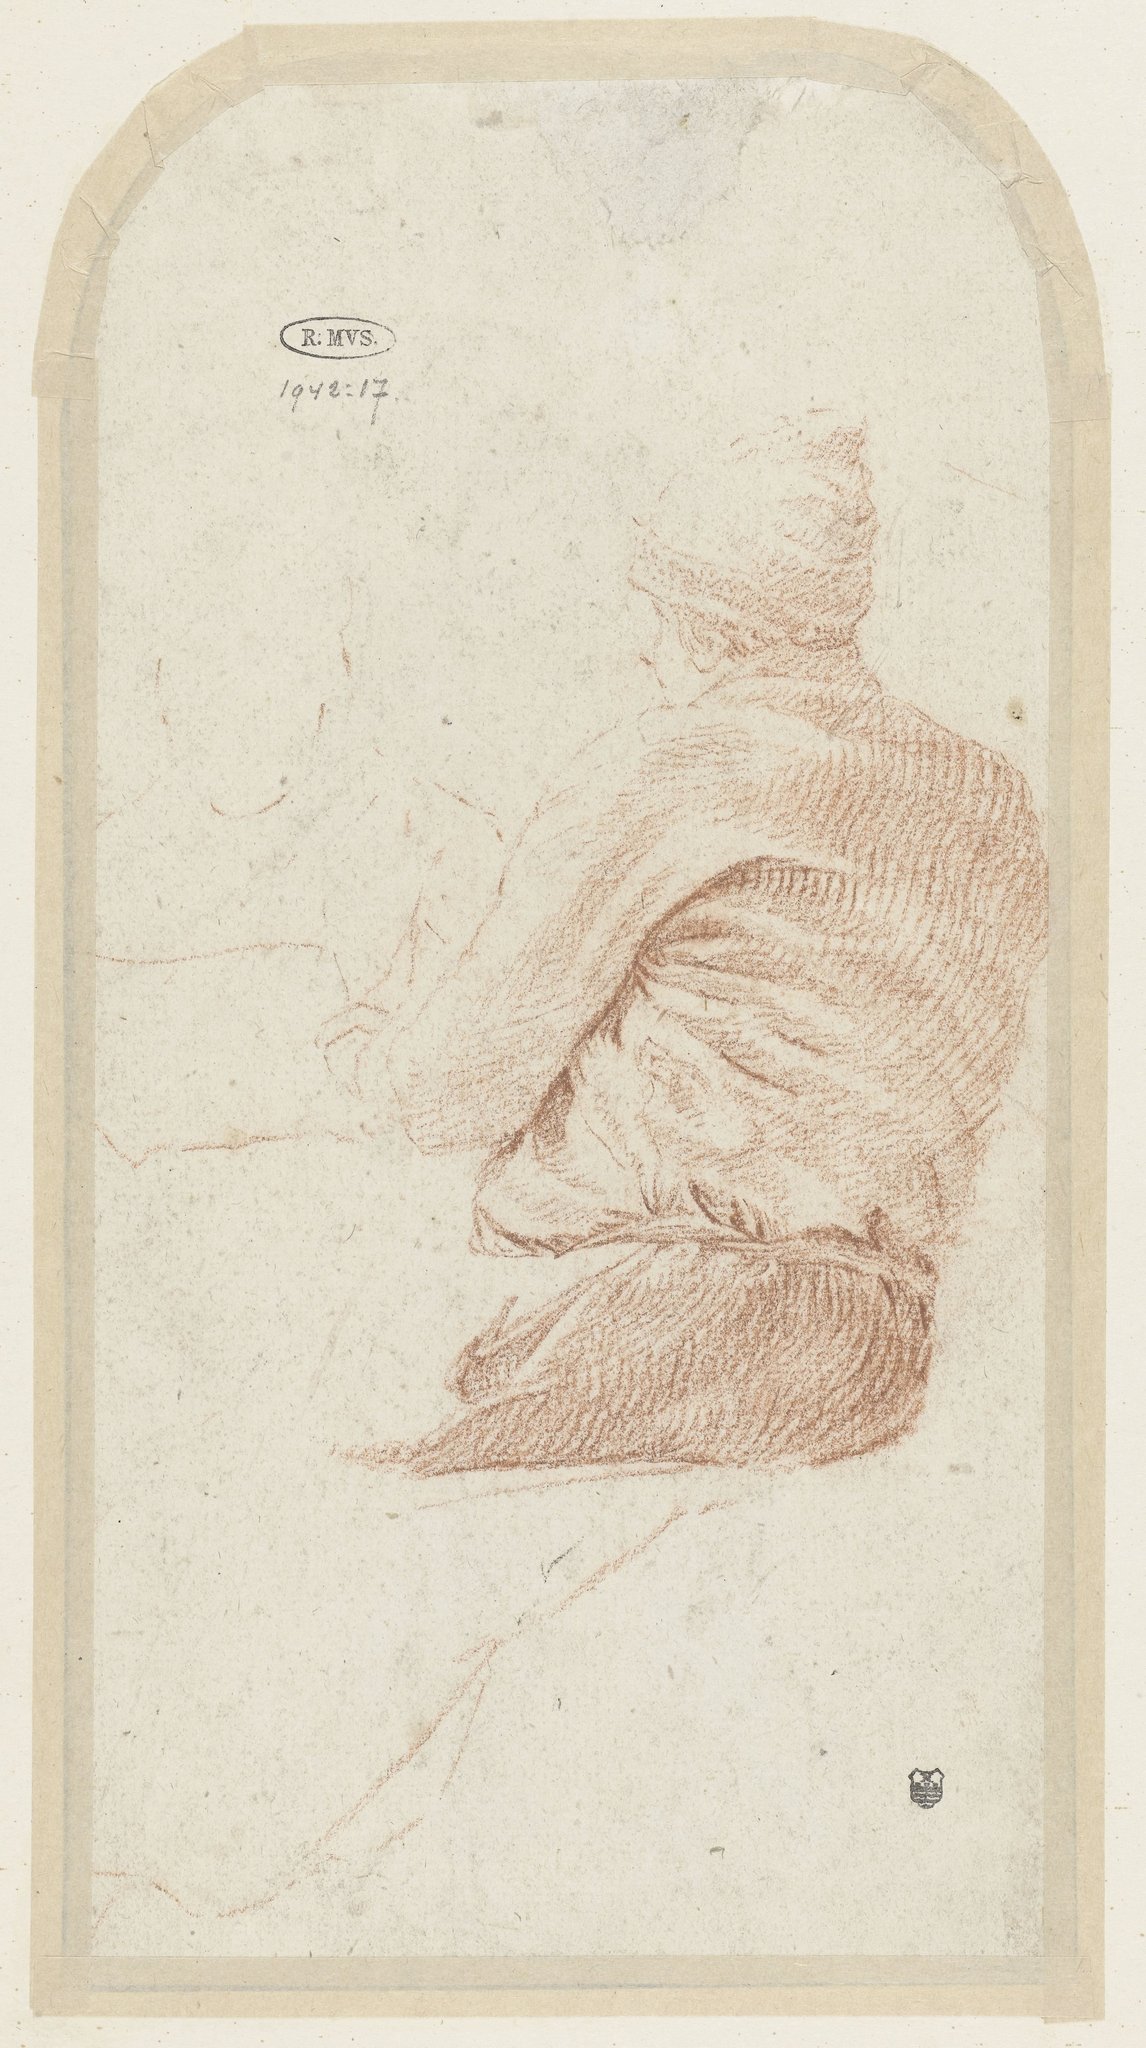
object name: drawing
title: Zittende man met muts op de rug gezien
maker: Anonymous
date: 1700-1800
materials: chalk, paper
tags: sitting figure